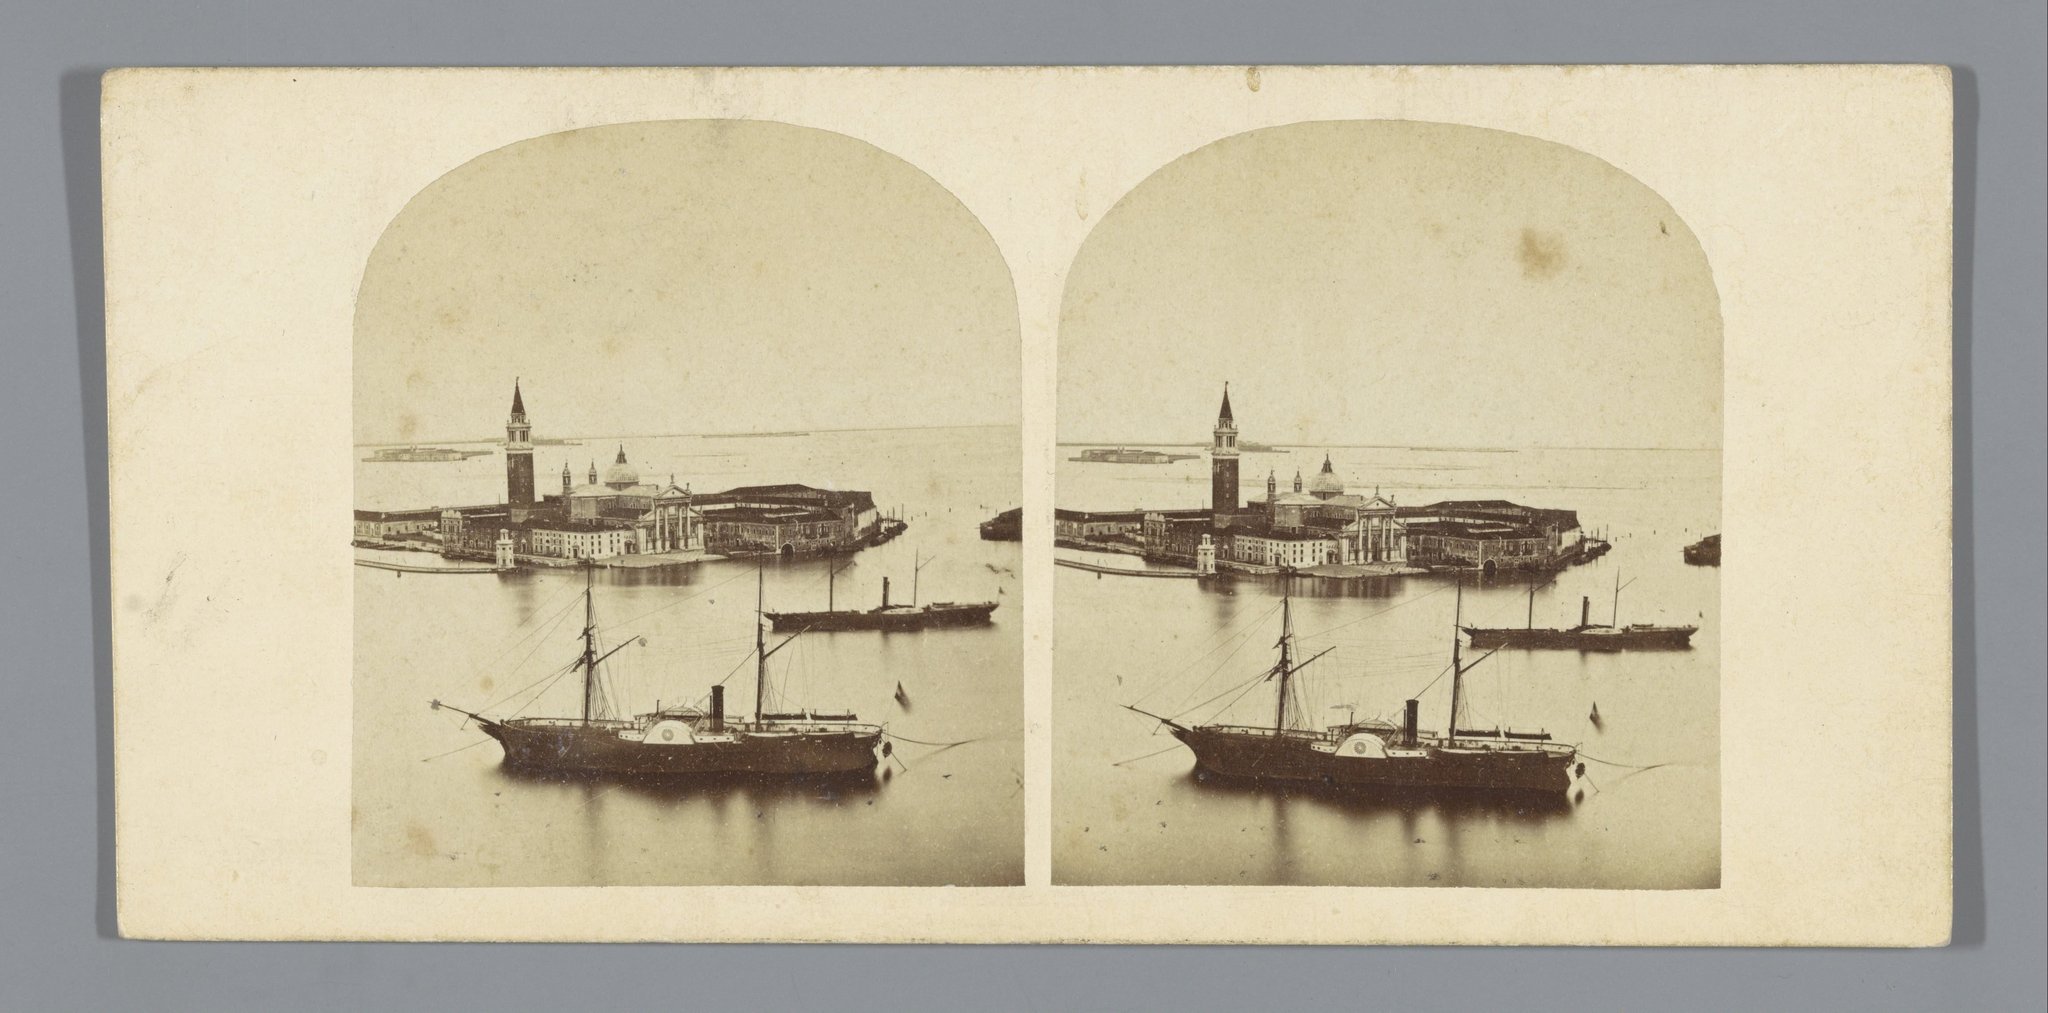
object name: stereograph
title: Gezicht op San Giorgio Maggiore te Venetië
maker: Anonymous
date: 1850-1880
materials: cardboard, photographic support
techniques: albumen print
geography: venice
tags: island, ships (in general)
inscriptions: inscription: ‘Ile st Georges Venise’